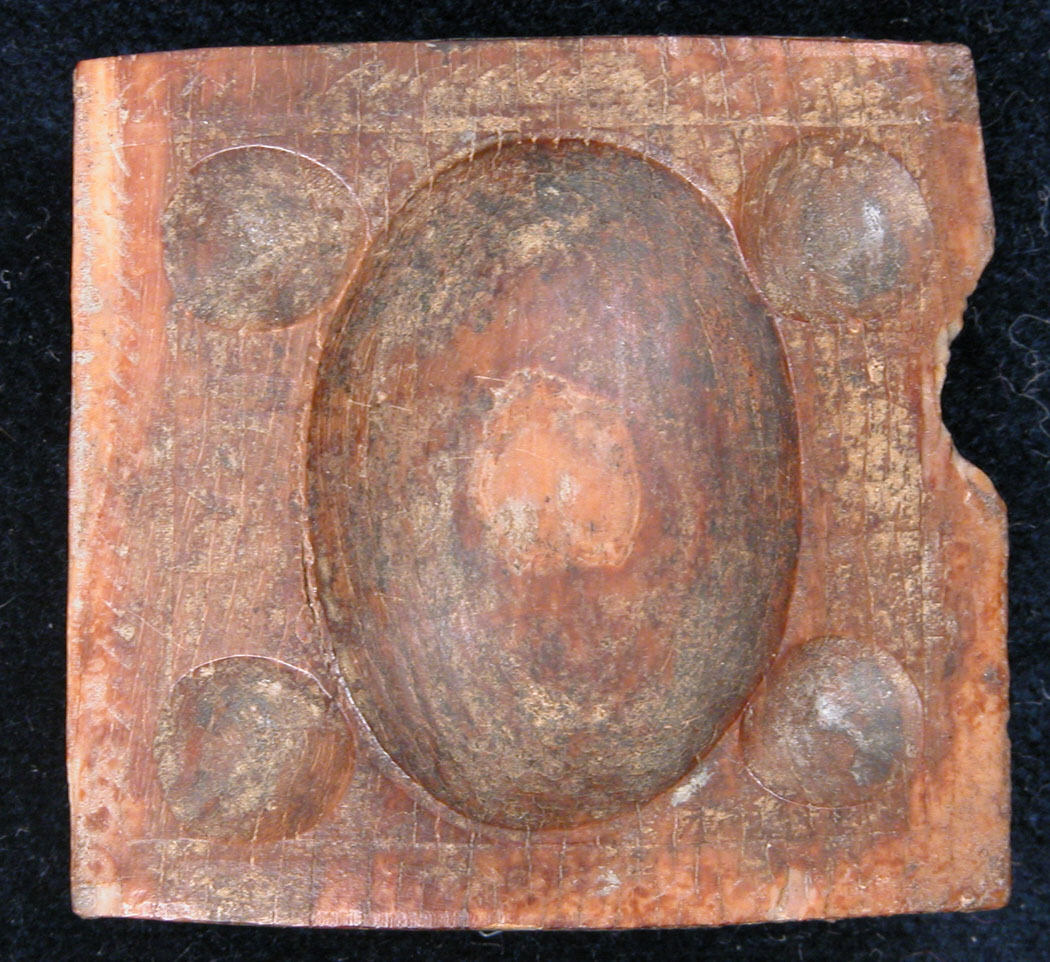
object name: palette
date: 901-1100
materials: ivory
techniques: carving, incising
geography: iran